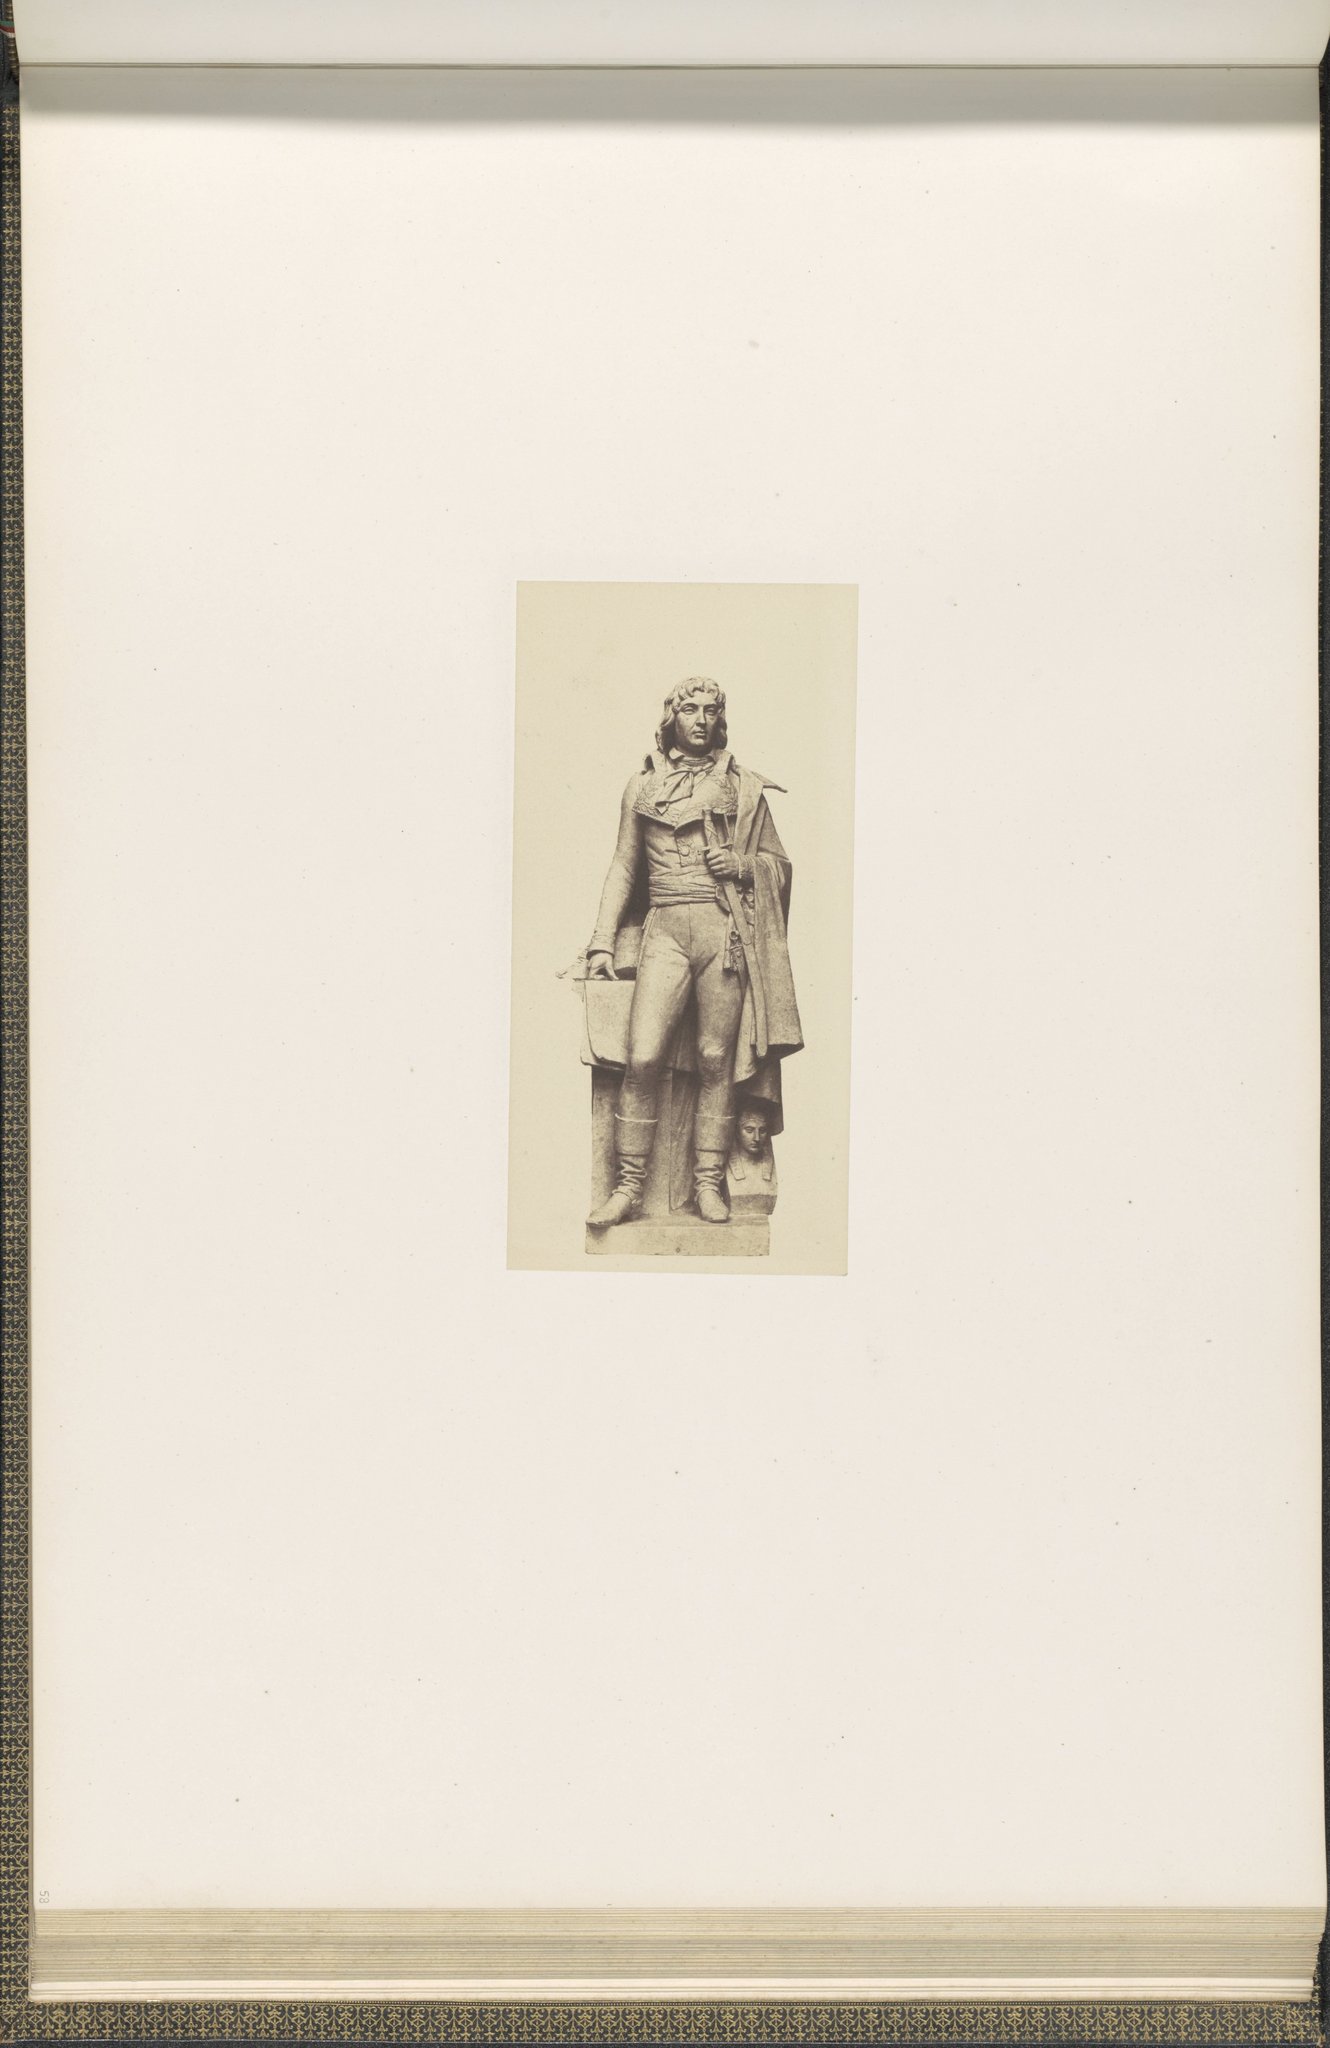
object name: photograph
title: Gipsmodel voor beeldhouwwerk op het Palais du Louvre: "Desaix" door Aristide Husson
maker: édouard denis baldus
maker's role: fotograaf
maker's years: 1813-1889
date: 1855-1857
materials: paper, photographic support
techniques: salted paper print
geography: paris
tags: piece of sculpture, reproduction of a piece of sculpture, permanent exhibition, museum, paris, tuileries palace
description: Onderdeel van Réunion des Tuileries au Louvre 1852-1857, album 4.